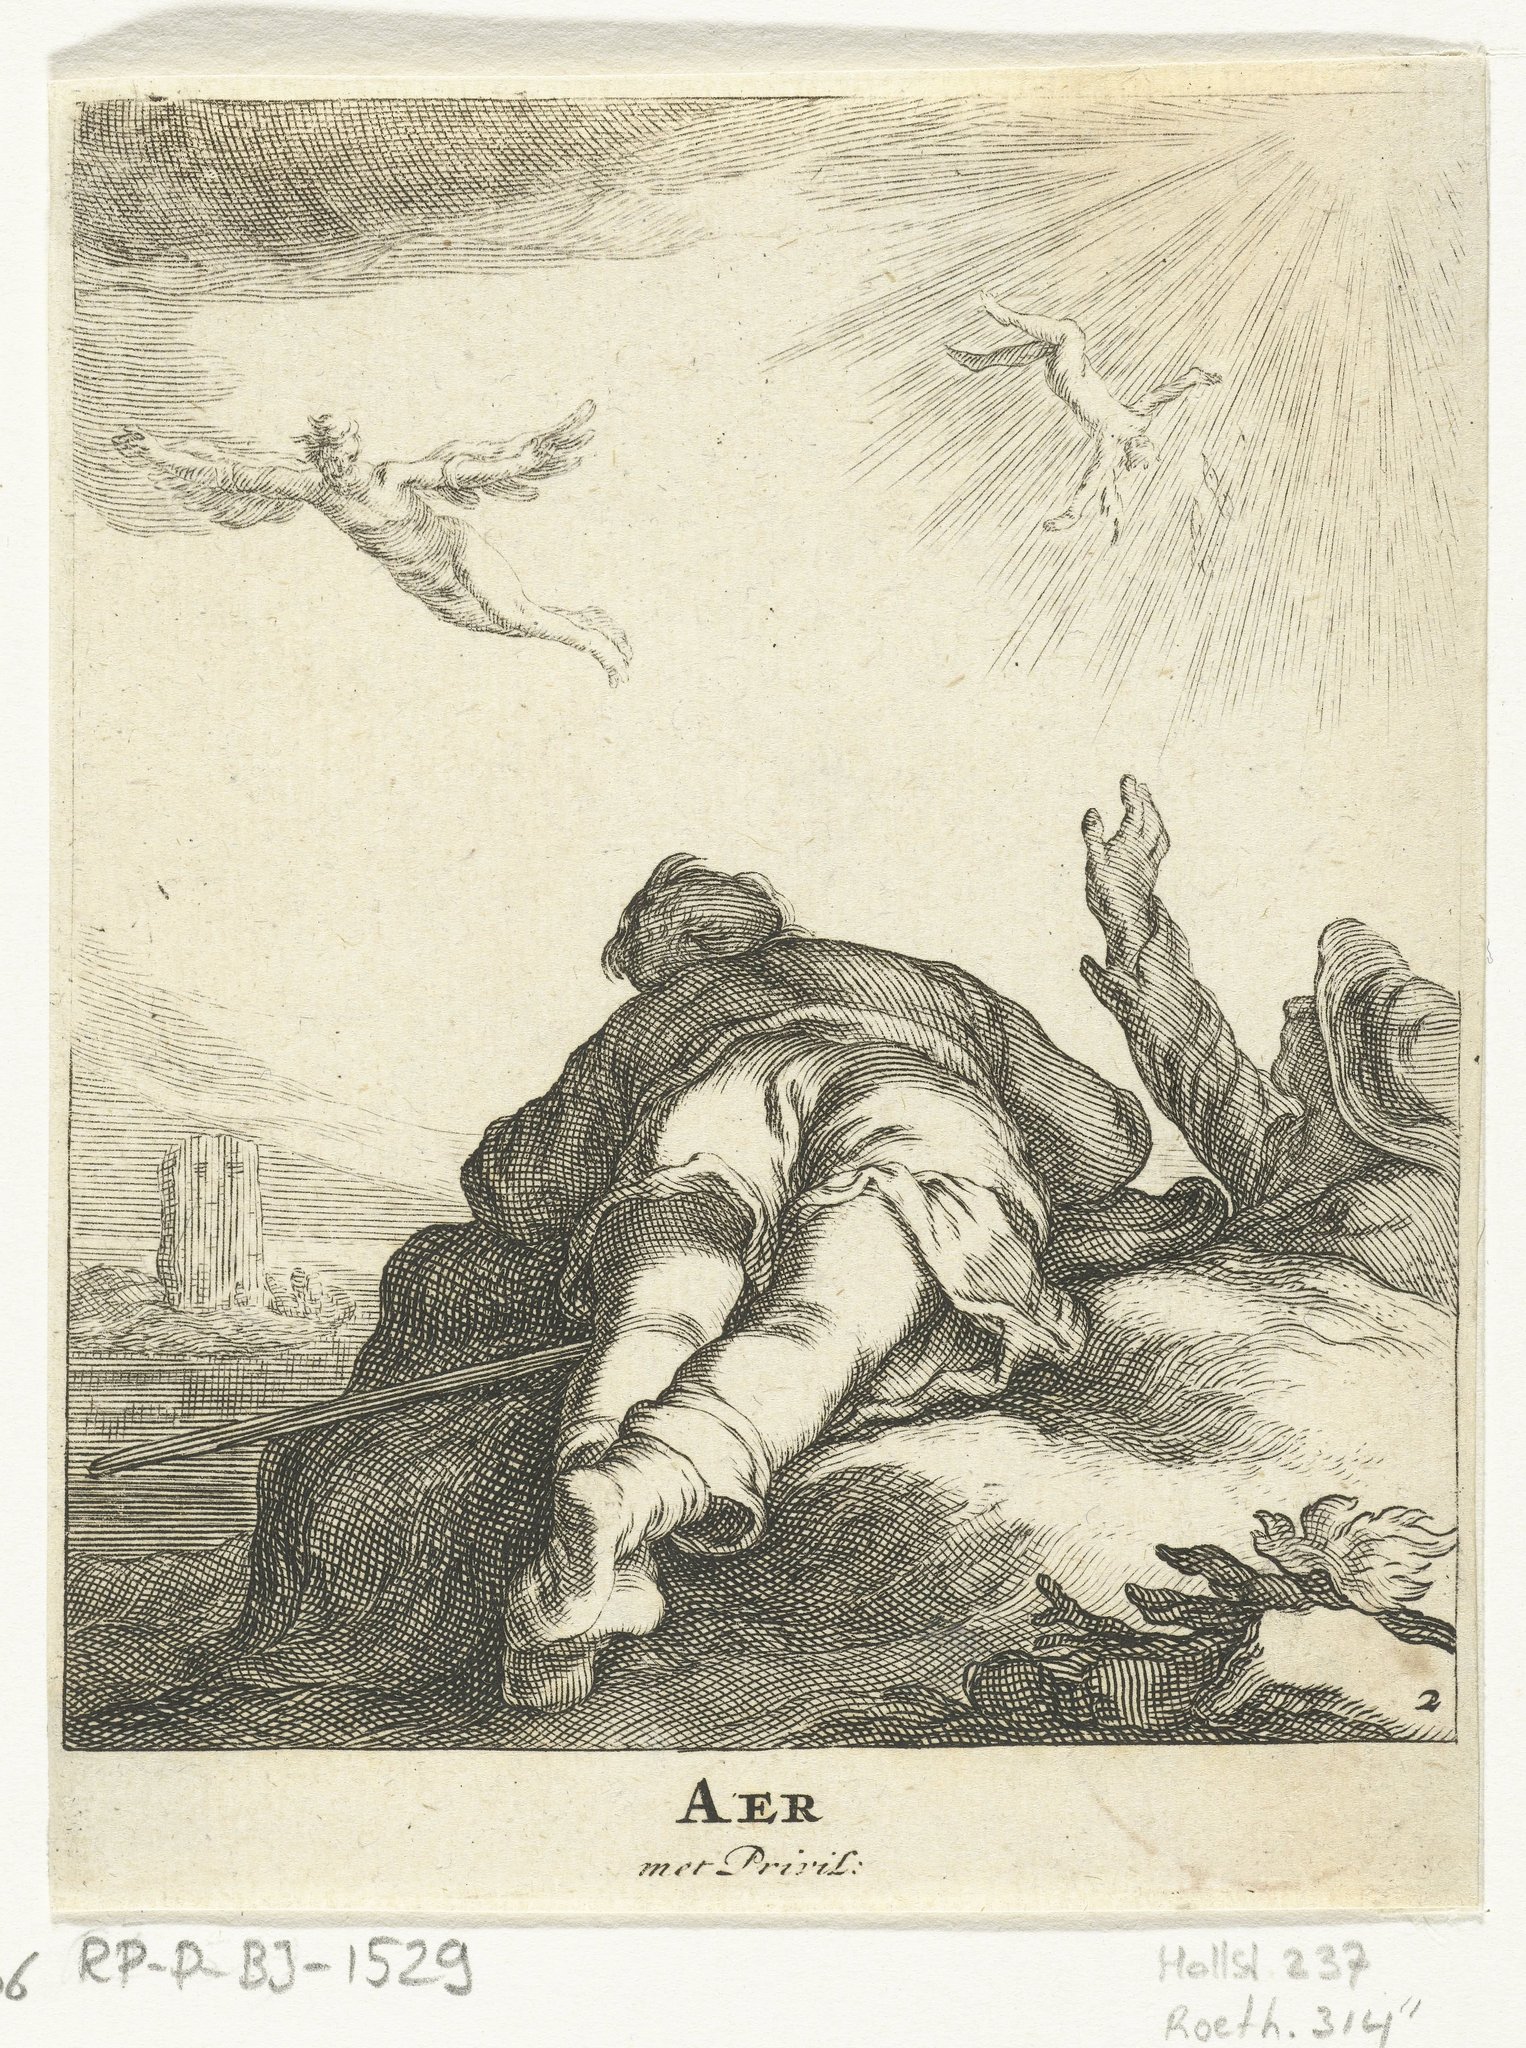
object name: print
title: Lucht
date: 1632-1670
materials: paper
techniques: engraving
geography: amsterdam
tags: air (one of the four elements), death i.e. the fall of icarus (daedalus present)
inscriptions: collector's mark: Lugt 240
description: Twee mannen, waarvan er één op zijn buik ligt, kijken in de lucht naar de val van Icarus.